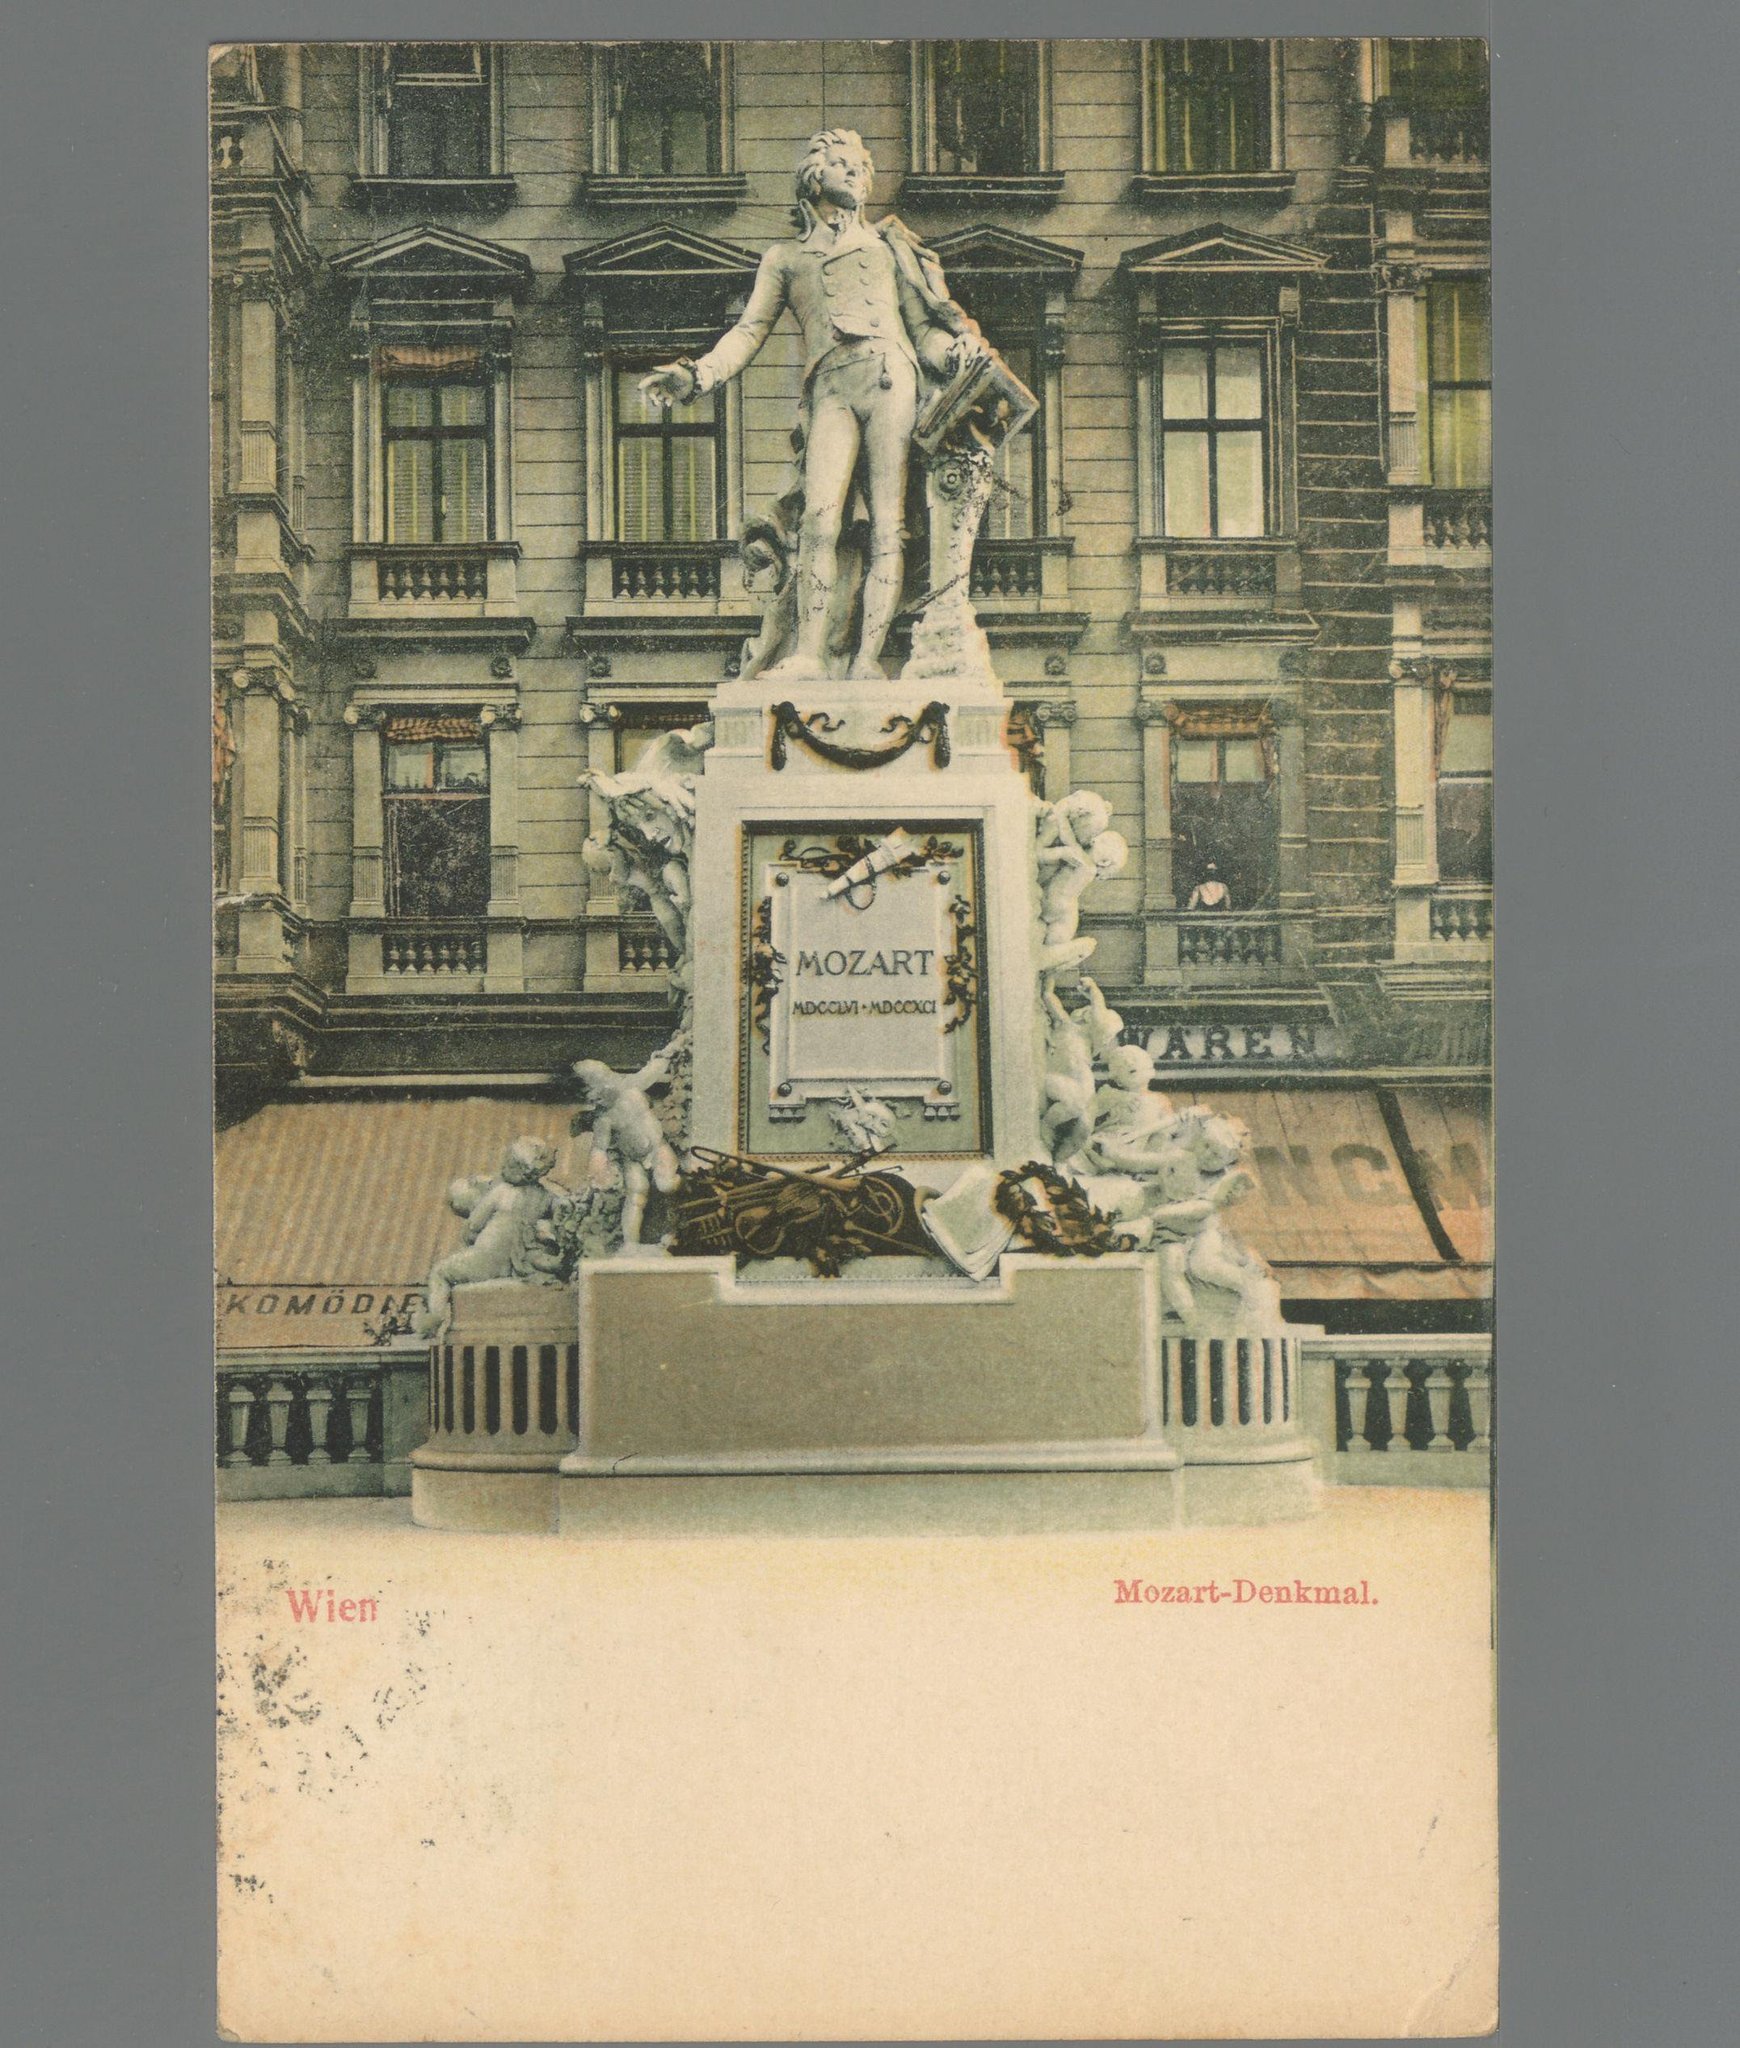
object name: ansichtkaart, prentbriefkaart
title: Wien. Mozart-Denkmal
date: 1890-1903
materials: cardboard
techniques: photograph, lithograph, writing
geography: vienna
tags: vienna, monument, statue, composer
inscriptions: inscription: ‘B.K.W.I.’, postage stamp